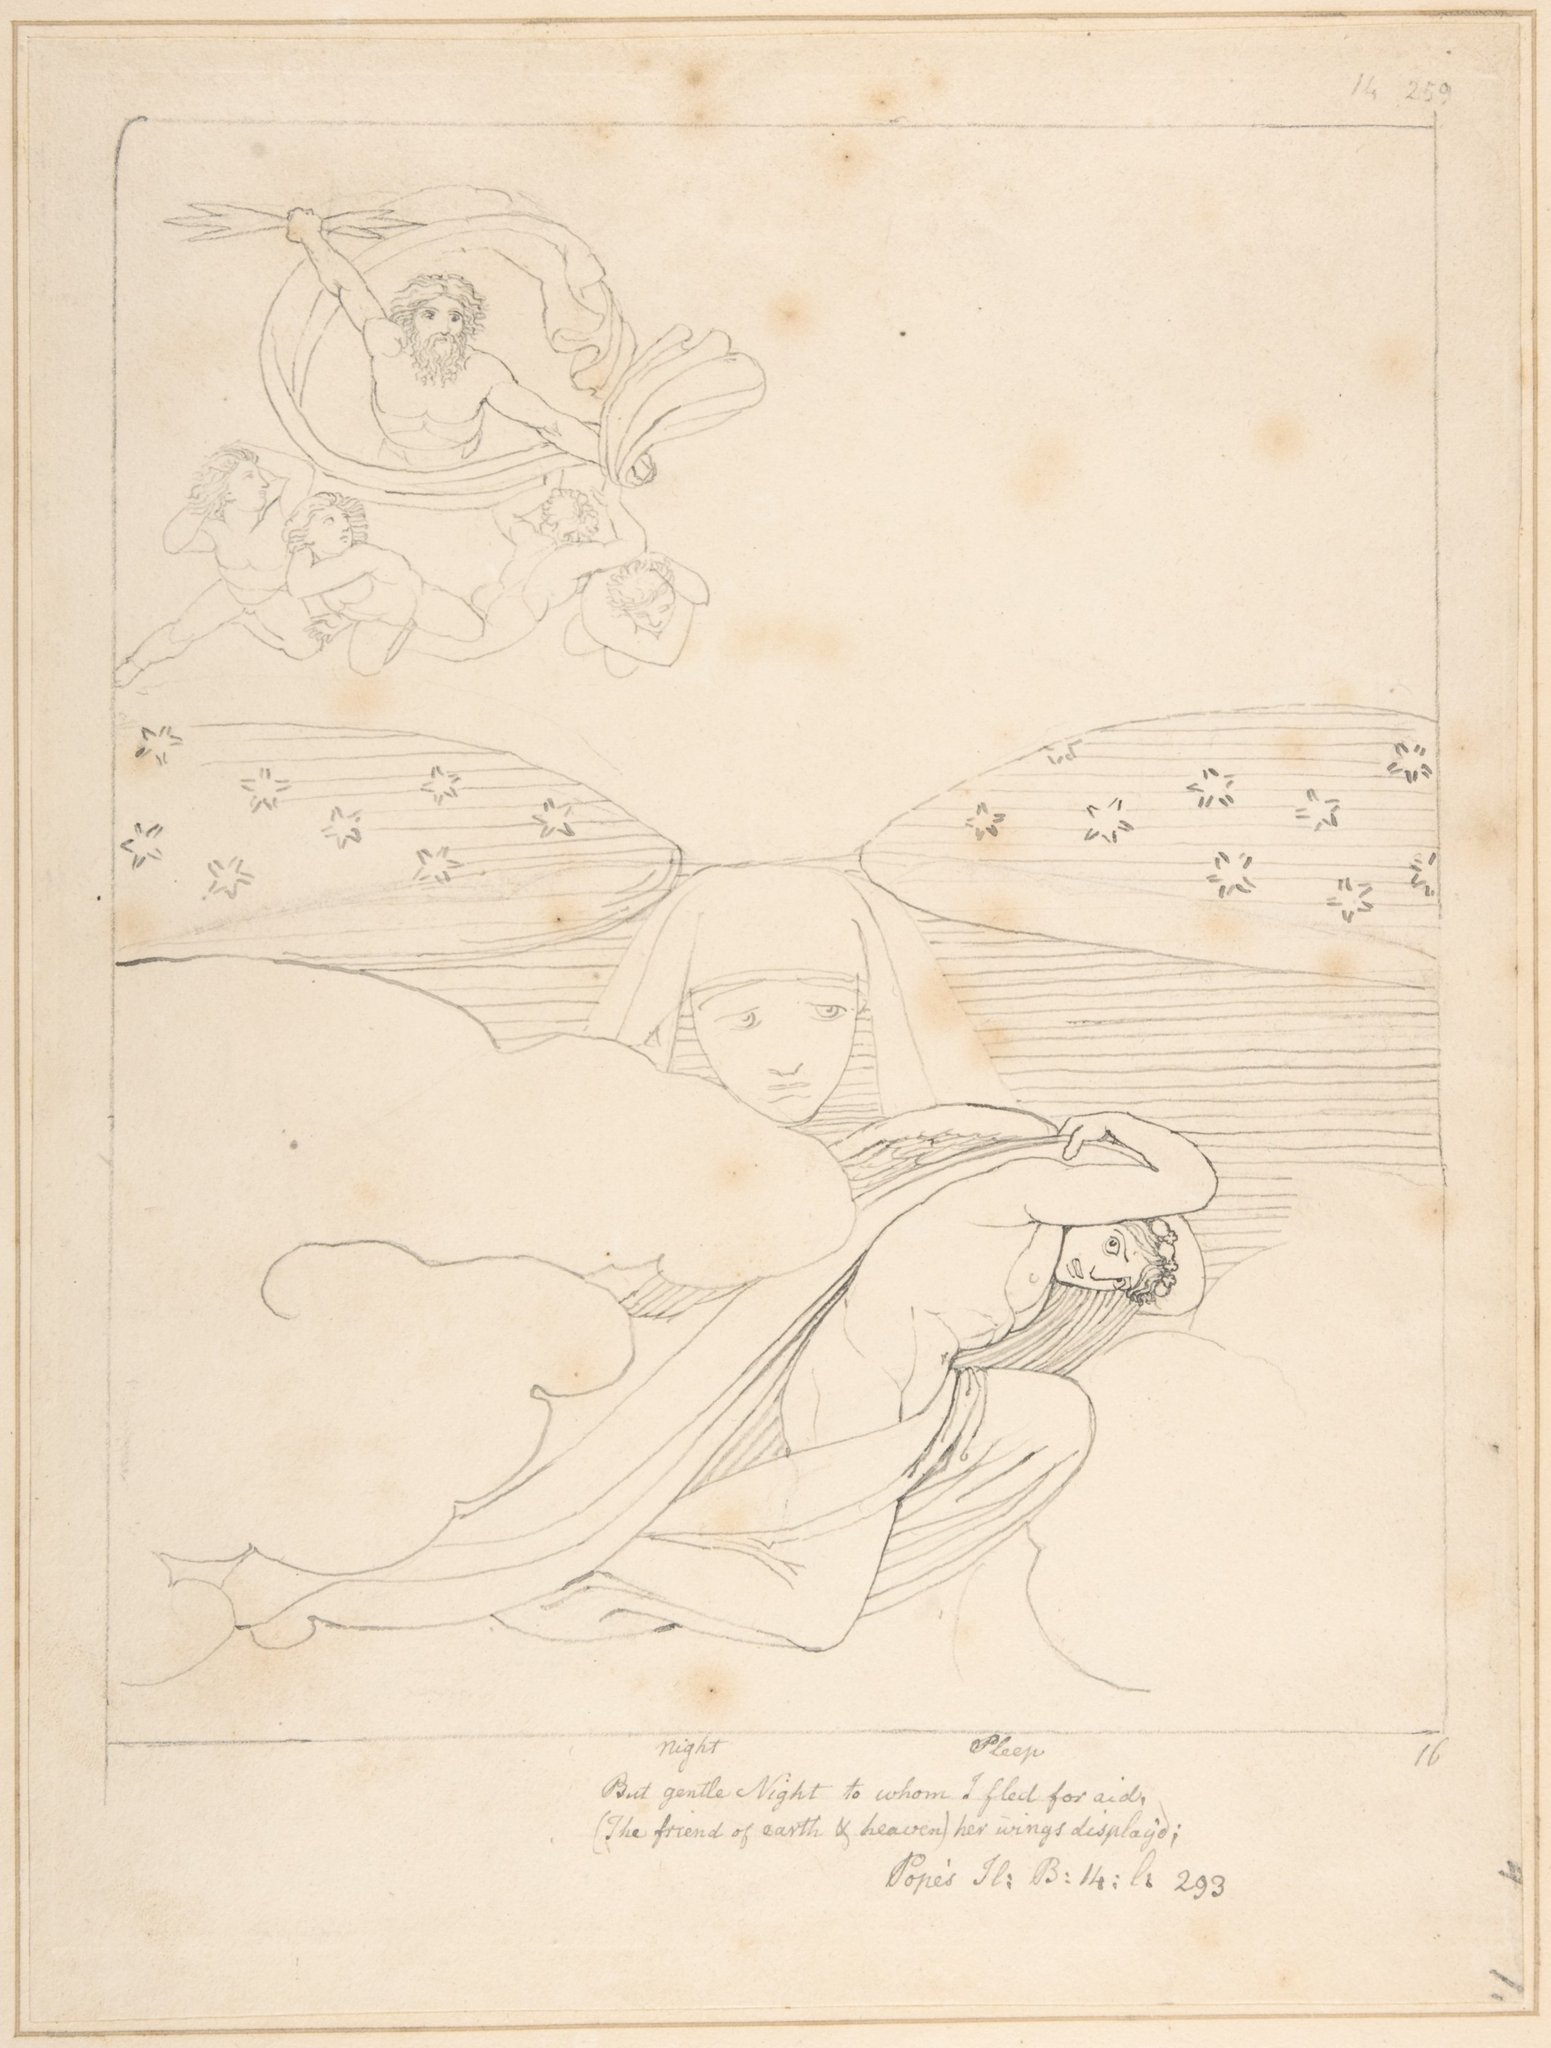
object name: drawing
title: Sleep Escaping from the Wrath of Jupiter – "But gentle Night to whom I fled for Aid (the Friend of Earth and Heaven), Her Wings Display'd" (Pope's Iliad, Book 14, line 293)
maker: john flaxman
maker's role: artist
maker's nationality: british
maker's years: 1755-1826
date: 1793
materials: graphite, ink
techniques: pen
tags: men